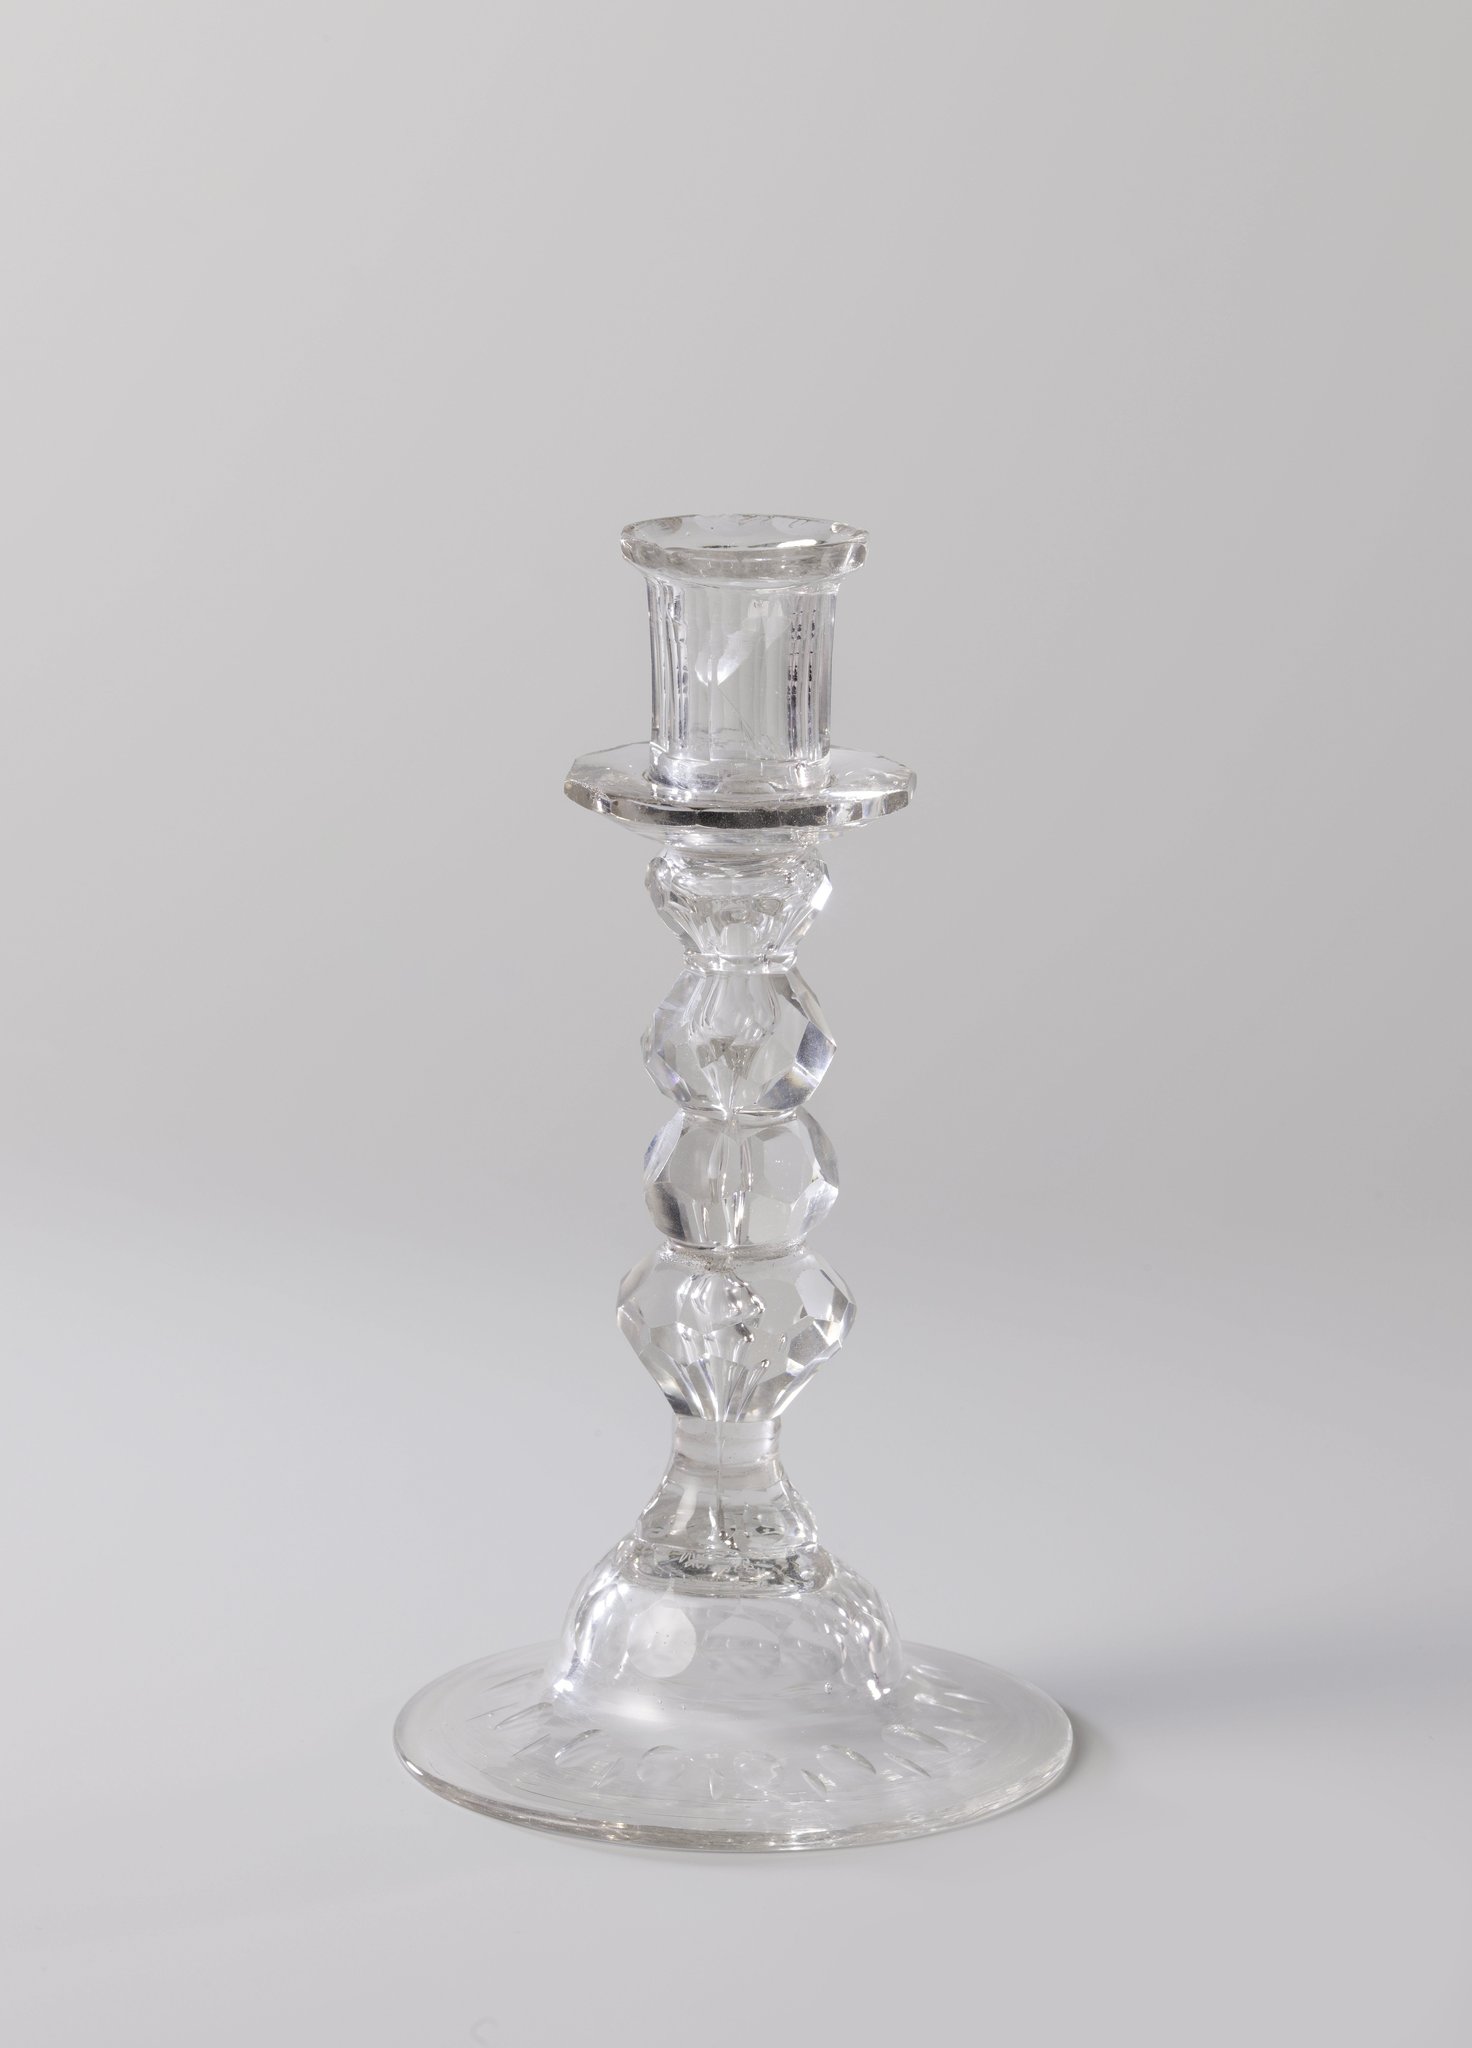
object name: candlestick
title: Kandelaar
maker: Anonymous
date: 1700-1800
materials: glass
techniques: glassblowing, grinding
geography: bohemia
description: Gewelfde voet met stam met vier nodi. Cilindrische kaarsenhouder met vetvanger en uitstaande rand. De voet met een ring geslepen ovalen tussen lijnen, de stam en de kaarsenhouder gefacetteerd.